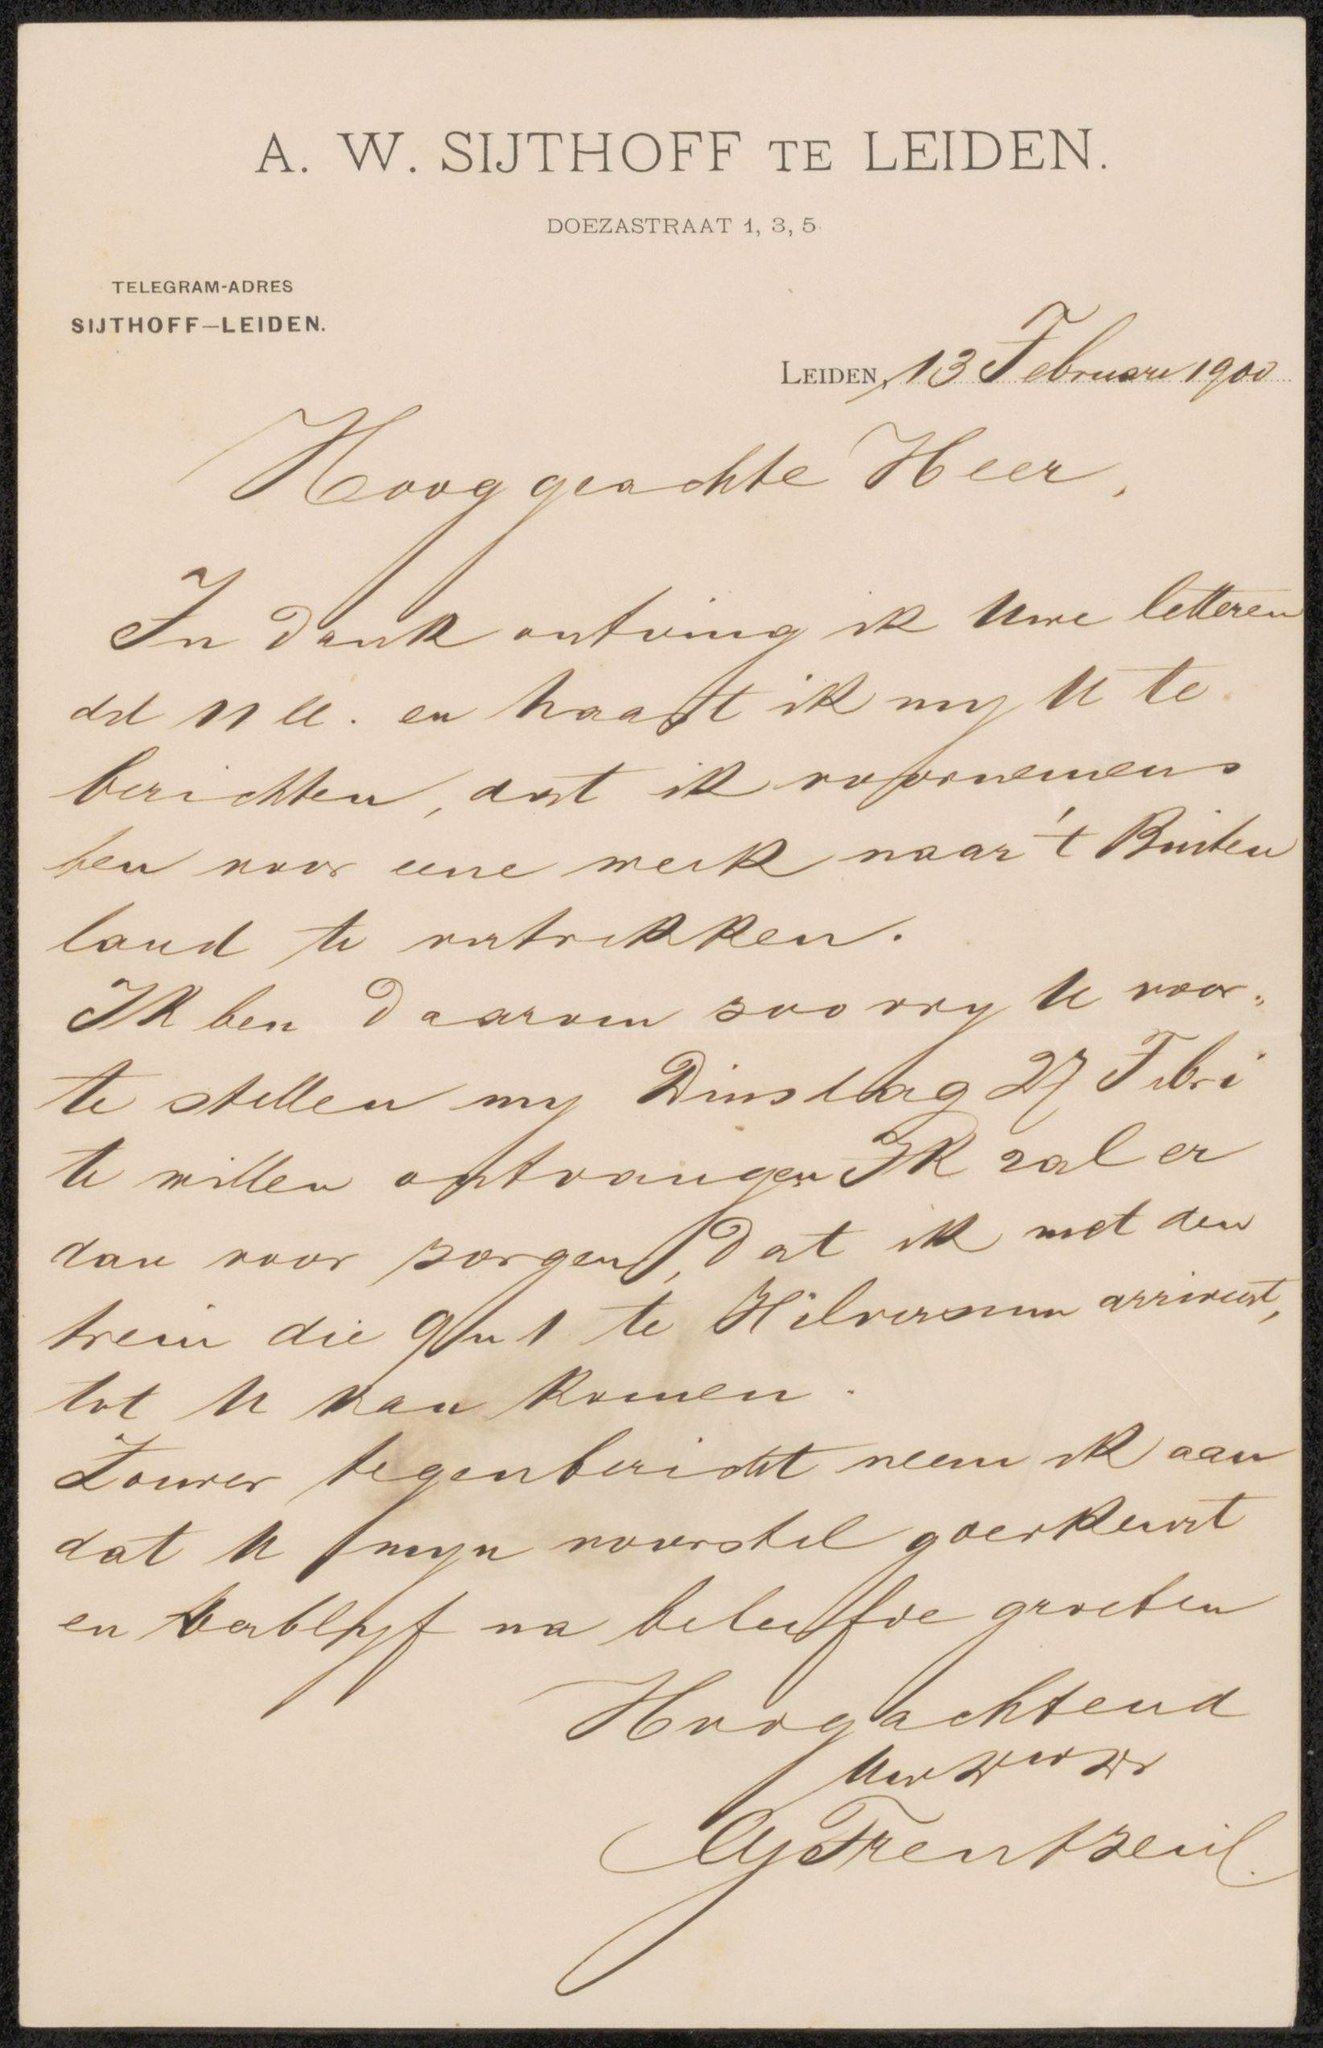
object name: letter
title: Brief aan Albert Neuhys (1844-1914)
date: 1900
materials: ink, paper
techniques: pen, printing, writing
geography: leiden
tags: standing figure, sitting figure - aa - female human figure, interior of the house, mother and baby or young child, kneeling figure